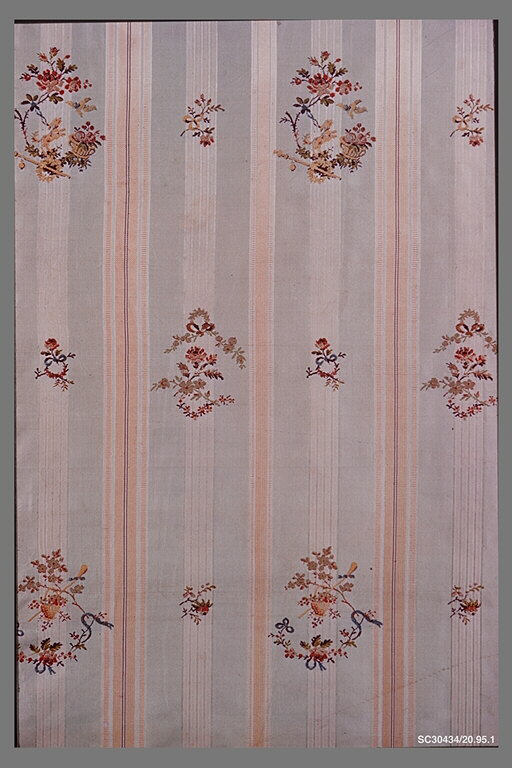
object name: piece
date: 1774-1792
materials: silk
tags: flowers,leaves